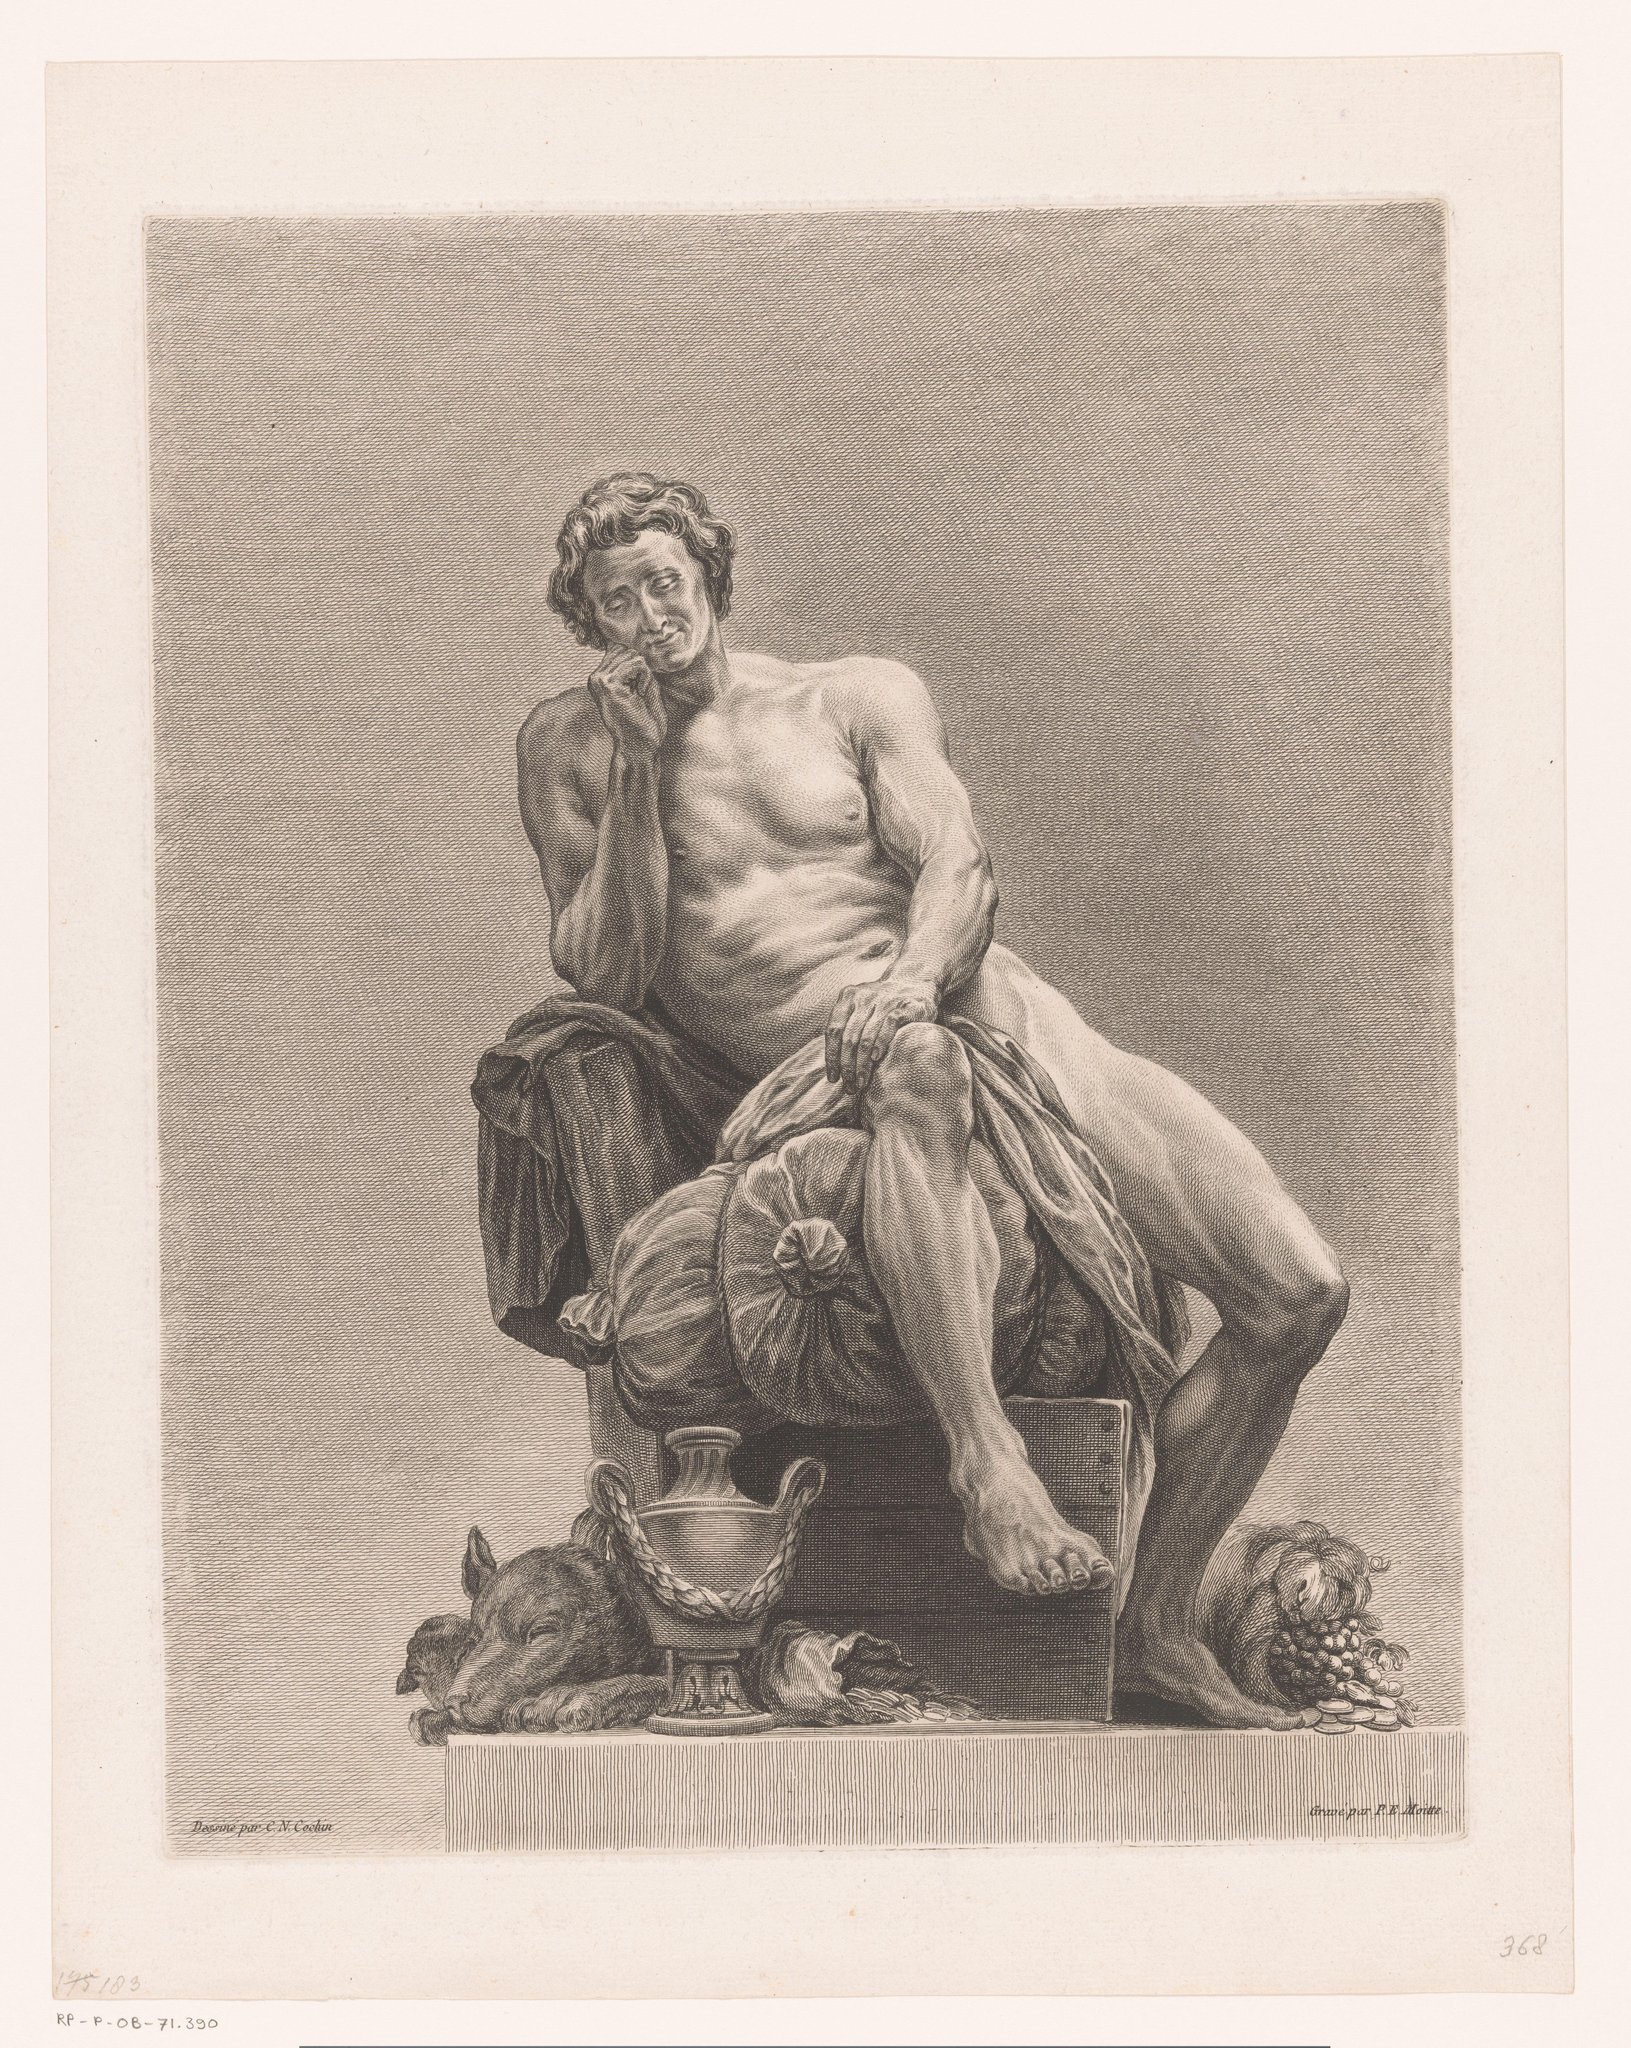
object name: print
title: Naakte man gezeten op kist waarop gevulde zakken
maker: pierre etienne moitte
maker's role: print maker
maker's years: 1722-1780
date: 1732-1780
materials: paper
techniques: engraving, etching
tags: 'cornucopia', horn of plenty, luggage, travel requisites, the (nude) human figure; 'corpo humano' (ripa), container of textile material: bag, sack, beasts of prey, predatory animals: wolf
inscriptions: collector's mark: Lugt 2228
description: Mogelijk een mannelijke personificatie van een werelddeel of stad.